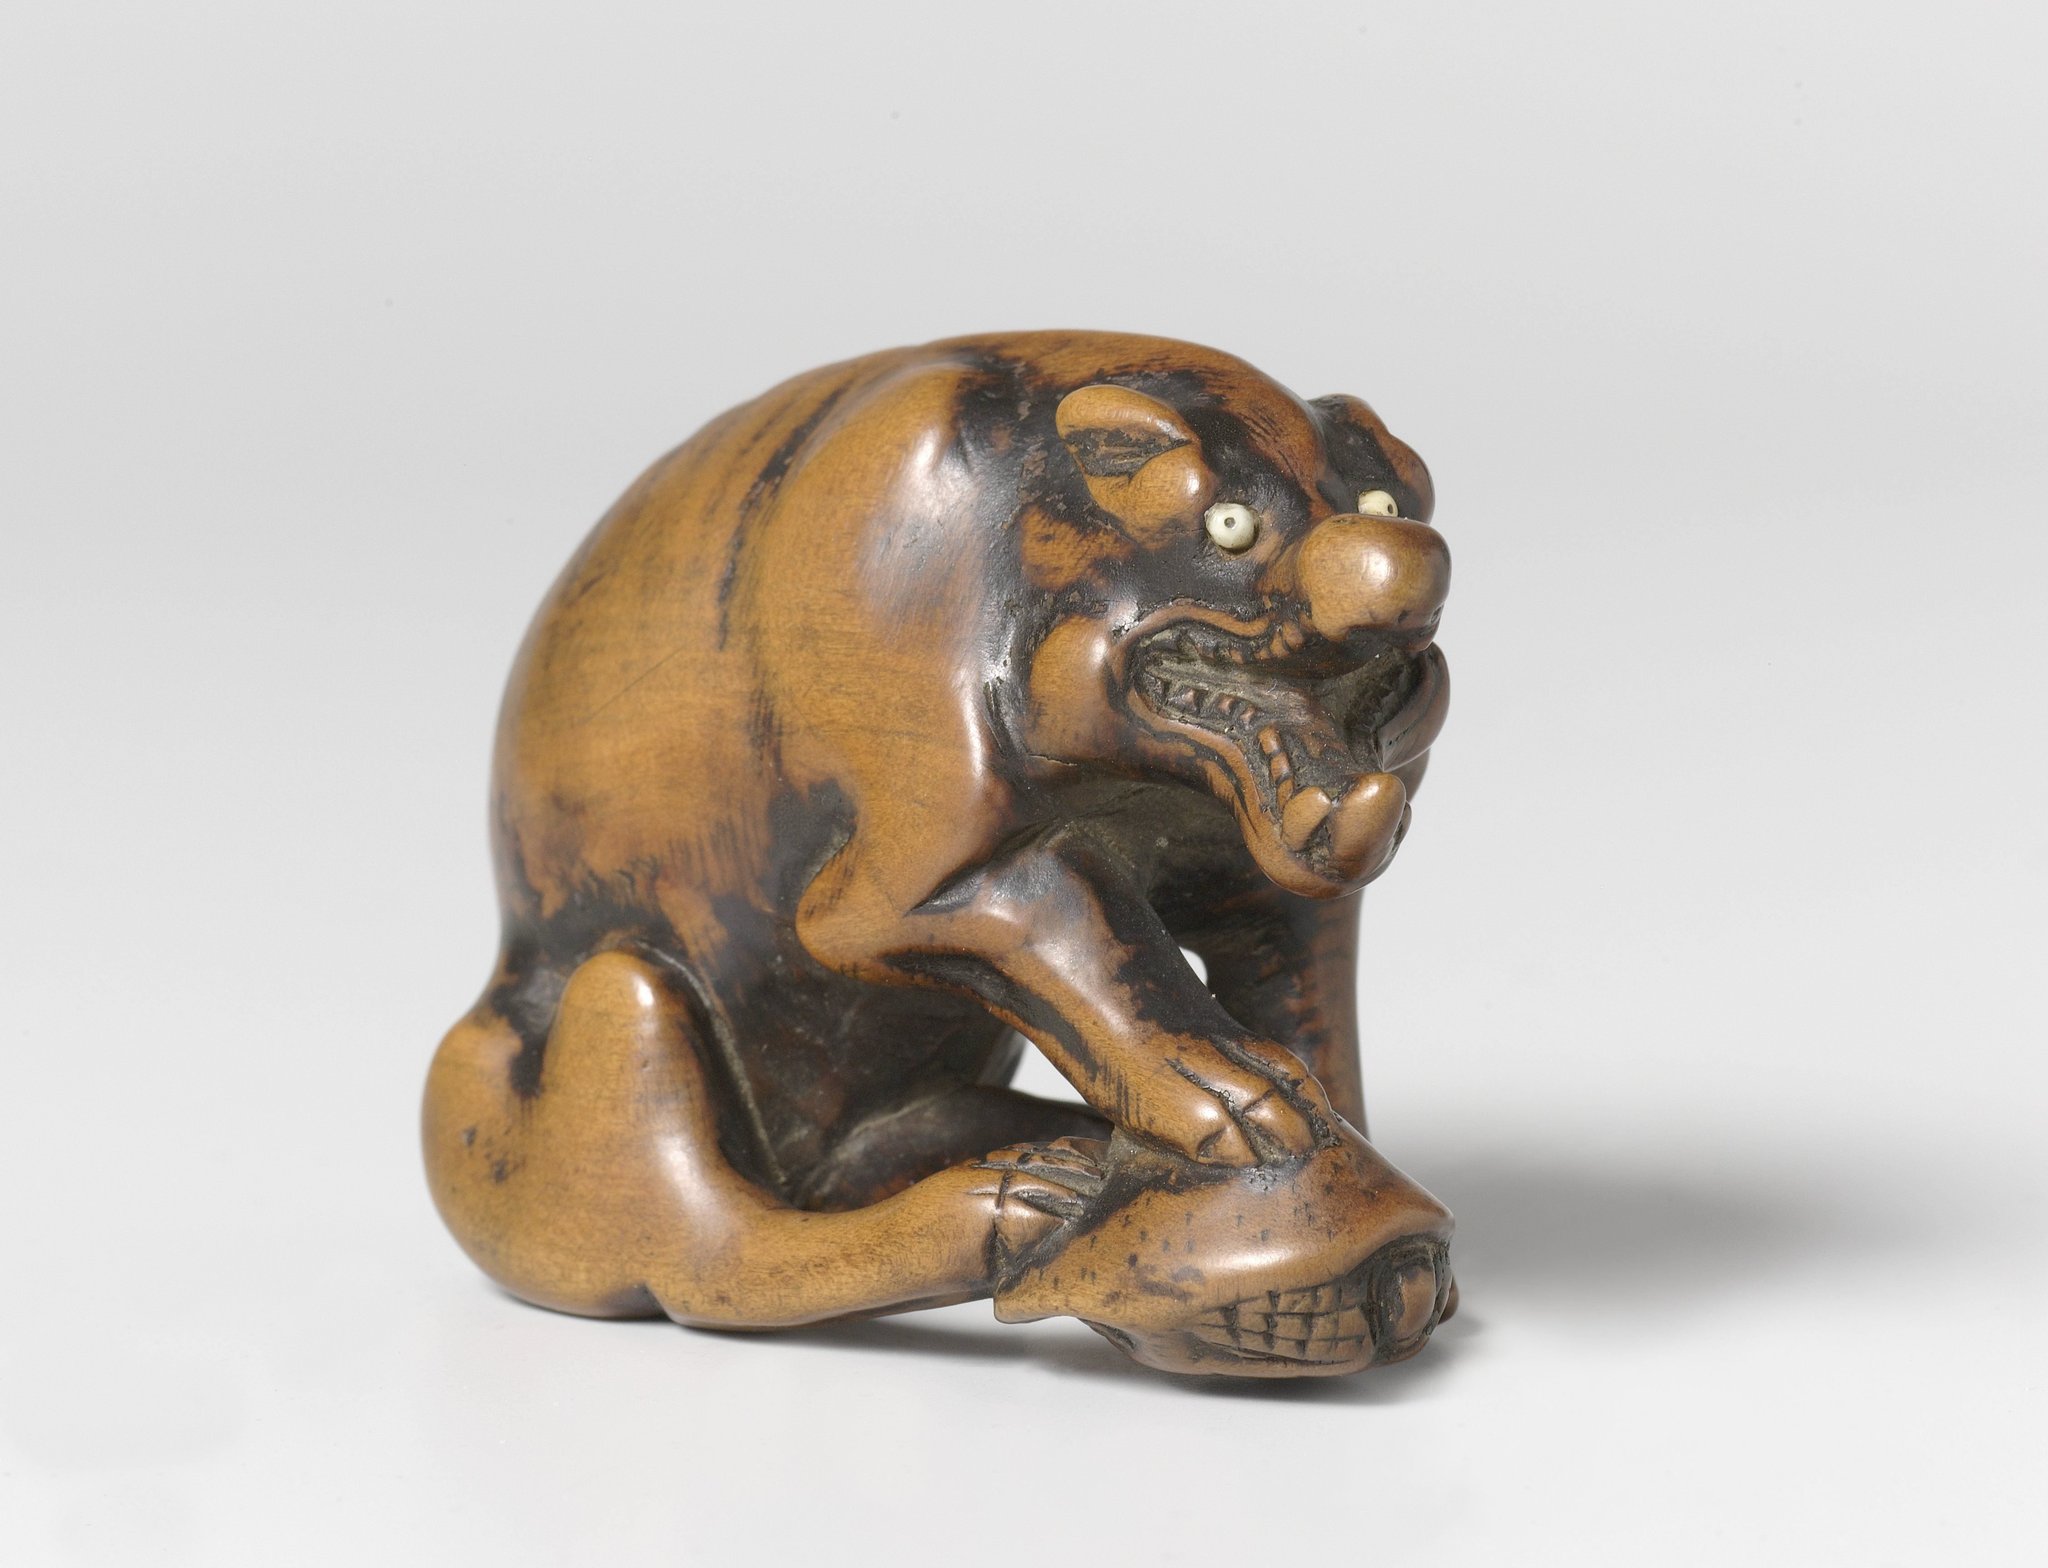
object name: netsuke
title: Netsuke in the form of a wolf with a turtle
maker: tomotada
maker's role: houtsnijder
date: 1800-1850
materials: wood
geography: japan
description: Wolf, waarvan de voorpoot op een schildpad rust. Gesigneerd "tomotada".